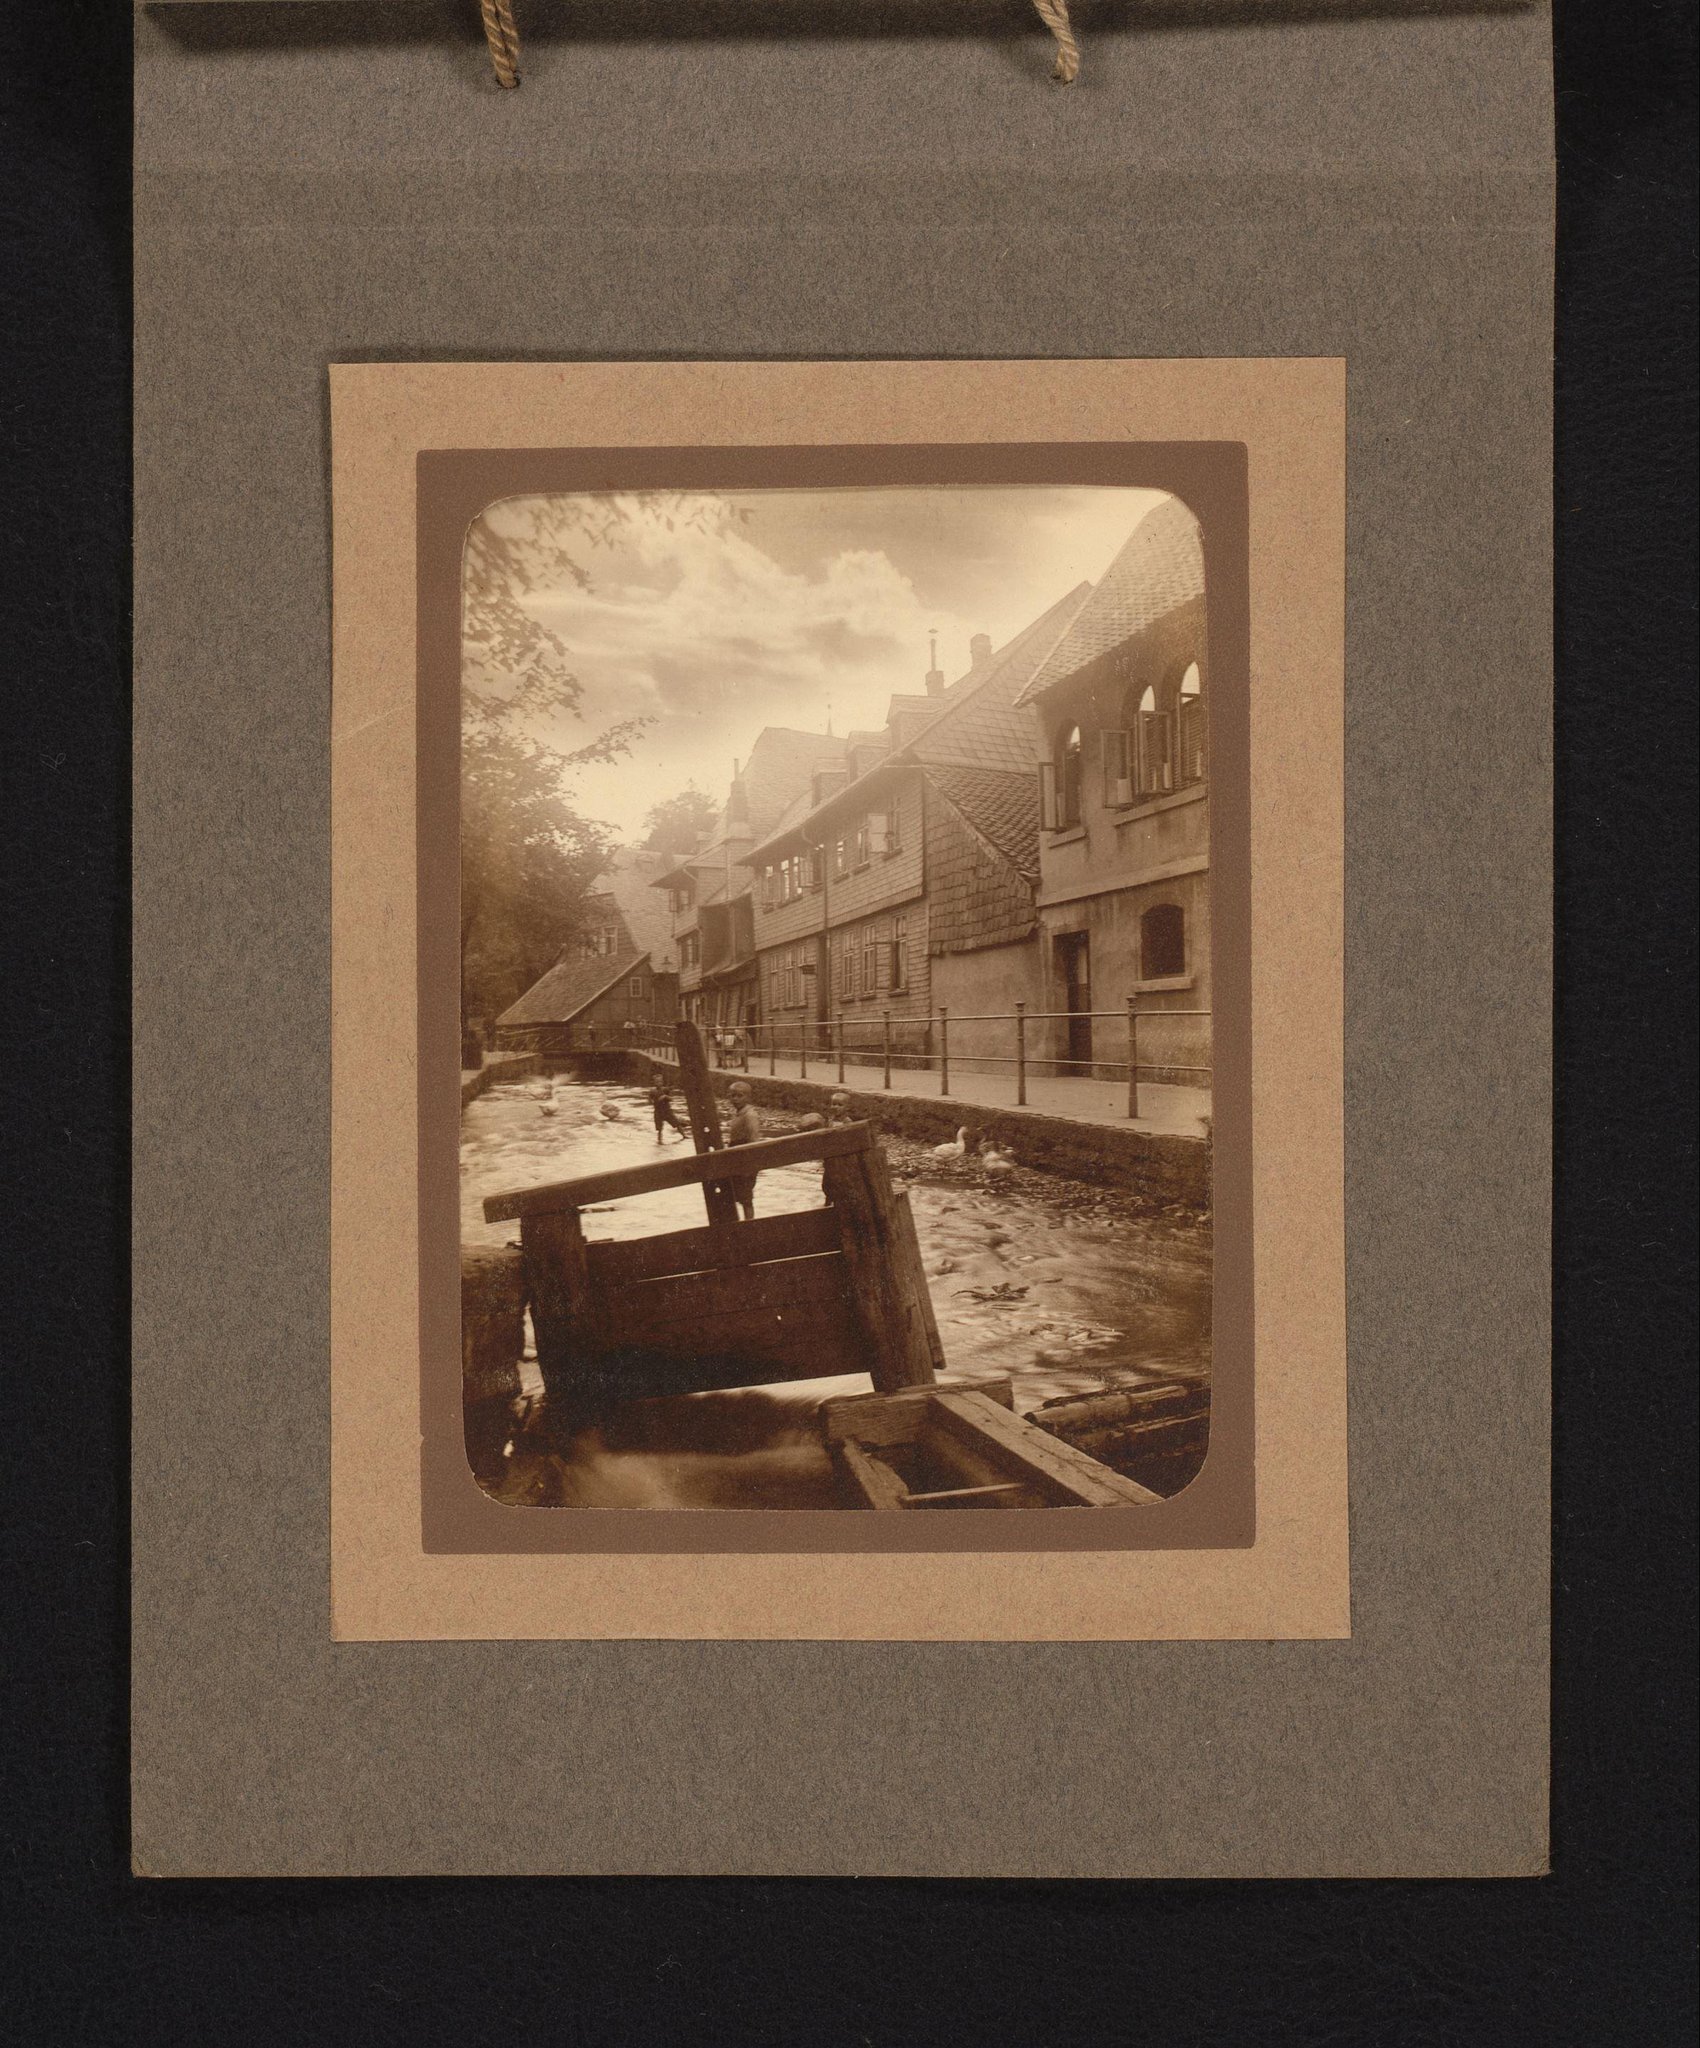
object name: photograph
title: Spelende kinderen in een stroom langs een rij huizen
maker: Anonymous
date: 1880-1930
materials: cardboard, photographic support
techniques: collodion silver print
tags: child, landscapes with waters, waterscapes, seascapes (in the temperate zone), civic architecture; edifices; dwellings